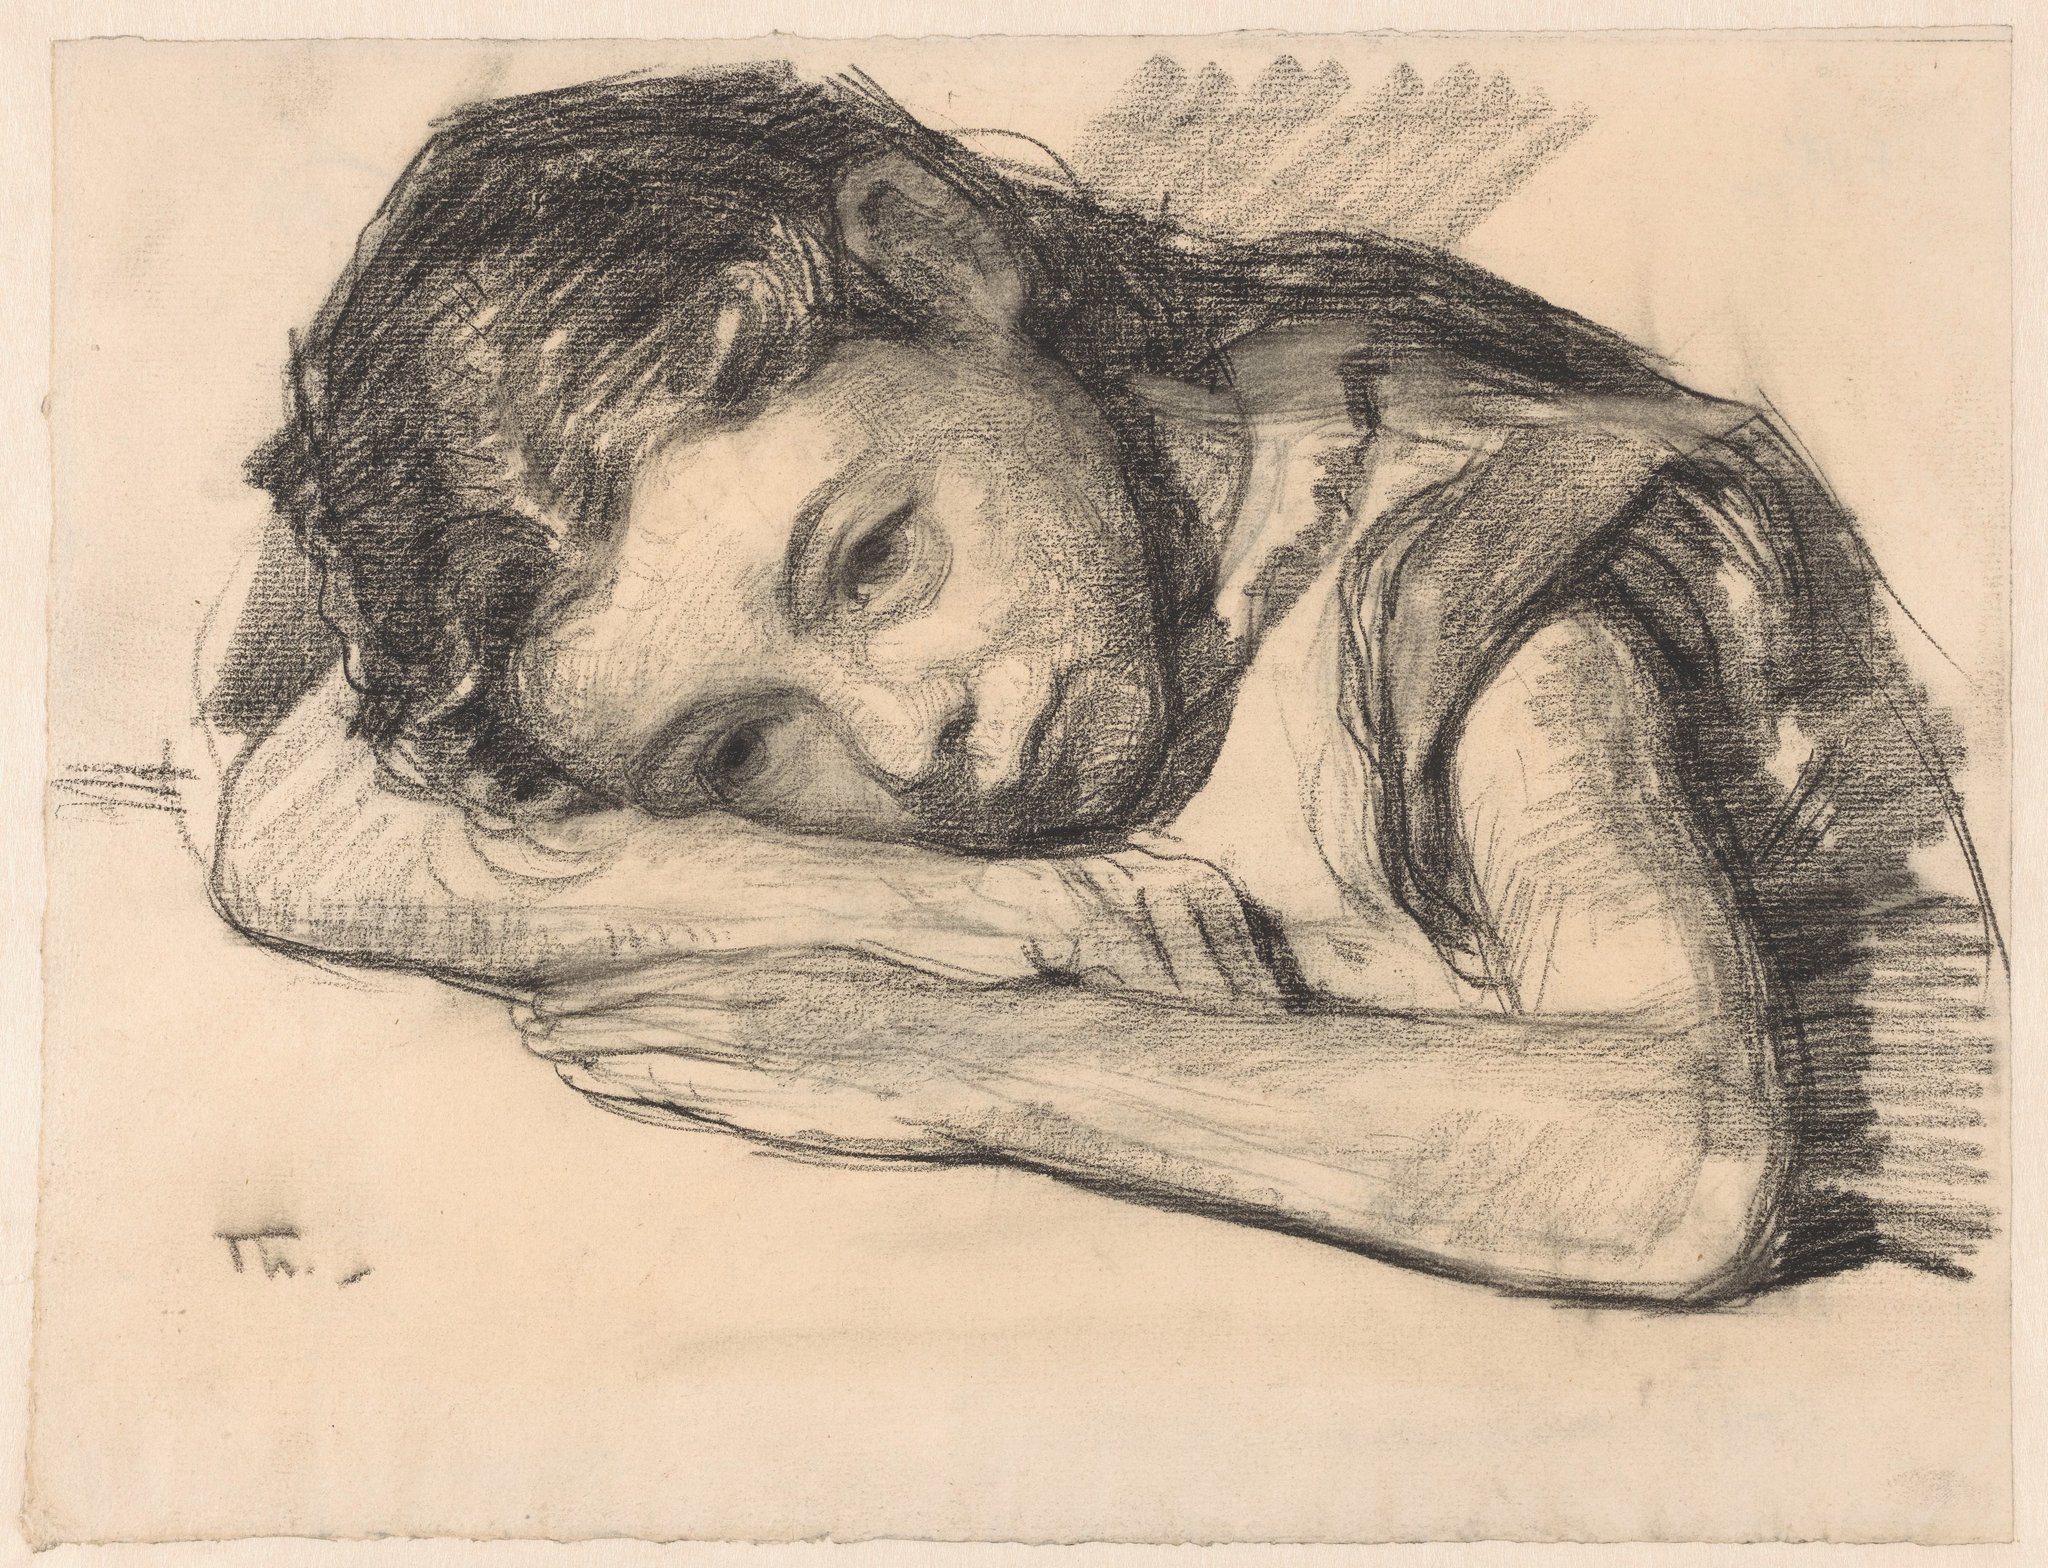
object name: drawing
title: Liesbeth of Dora Arntzenius als kind, op een arm geleund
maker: willem bastiaan tholen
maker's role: draughtsman, painter, print maker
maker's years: 1860-1931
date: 1870-1931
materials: chalk, paper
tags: dora arntzenius, liesbeth arntzenius